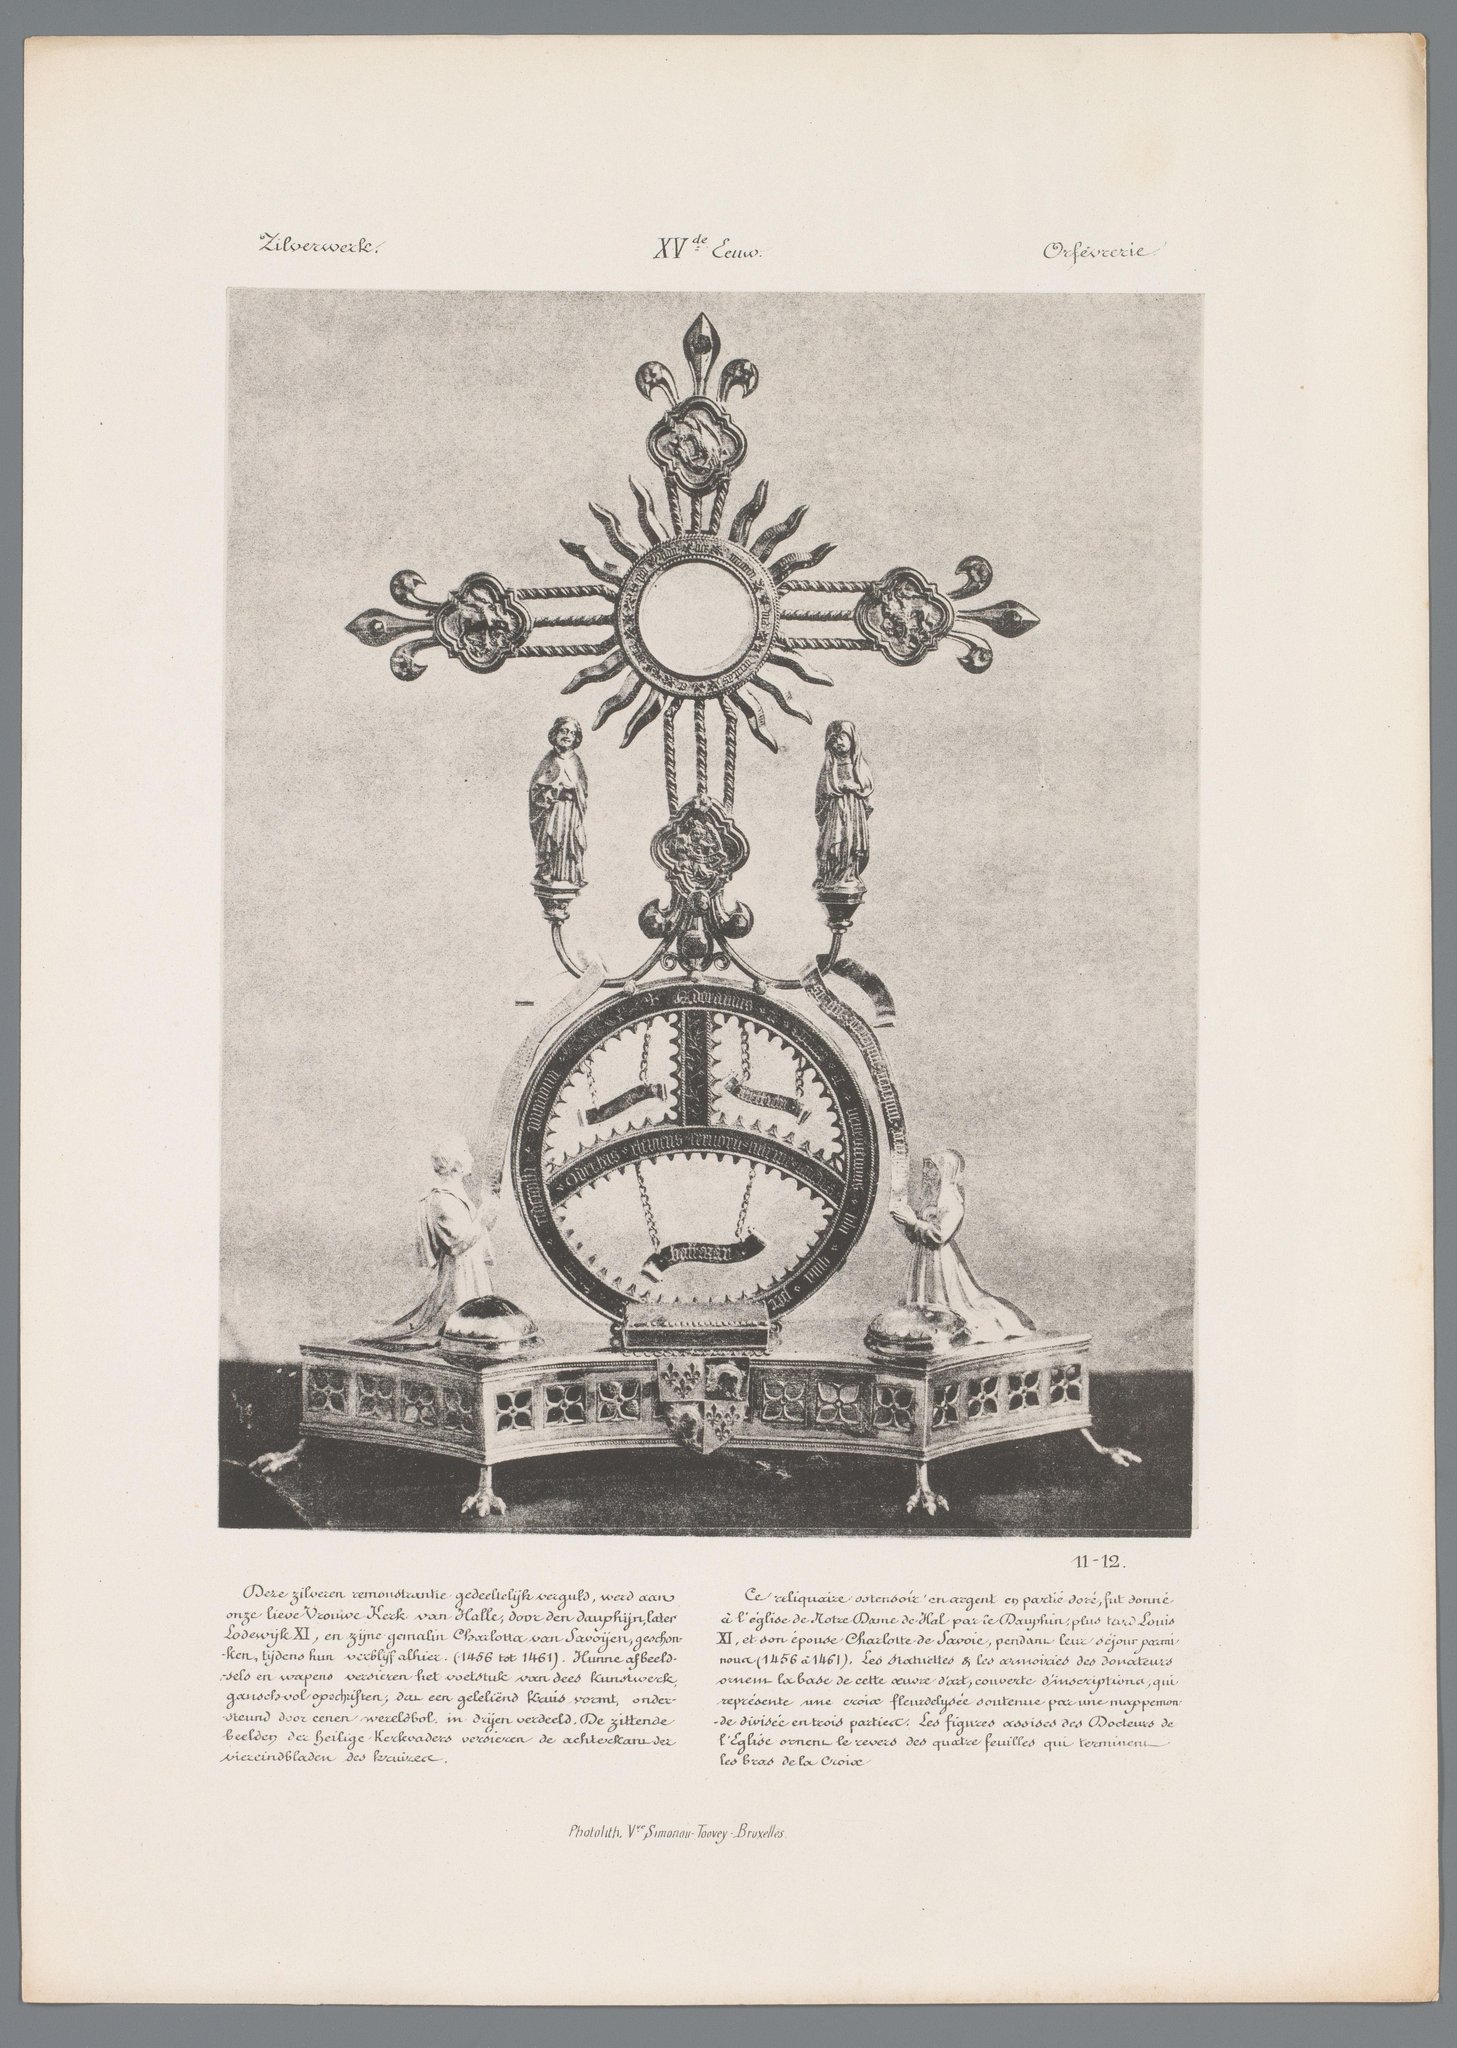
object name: photomechanical print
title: Reproductie van zilverwerk uit de vijftiende eeuw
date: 1855-1899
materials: paper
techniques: photolithography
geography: brussels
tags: work of applied art (+ metals ~ arts)